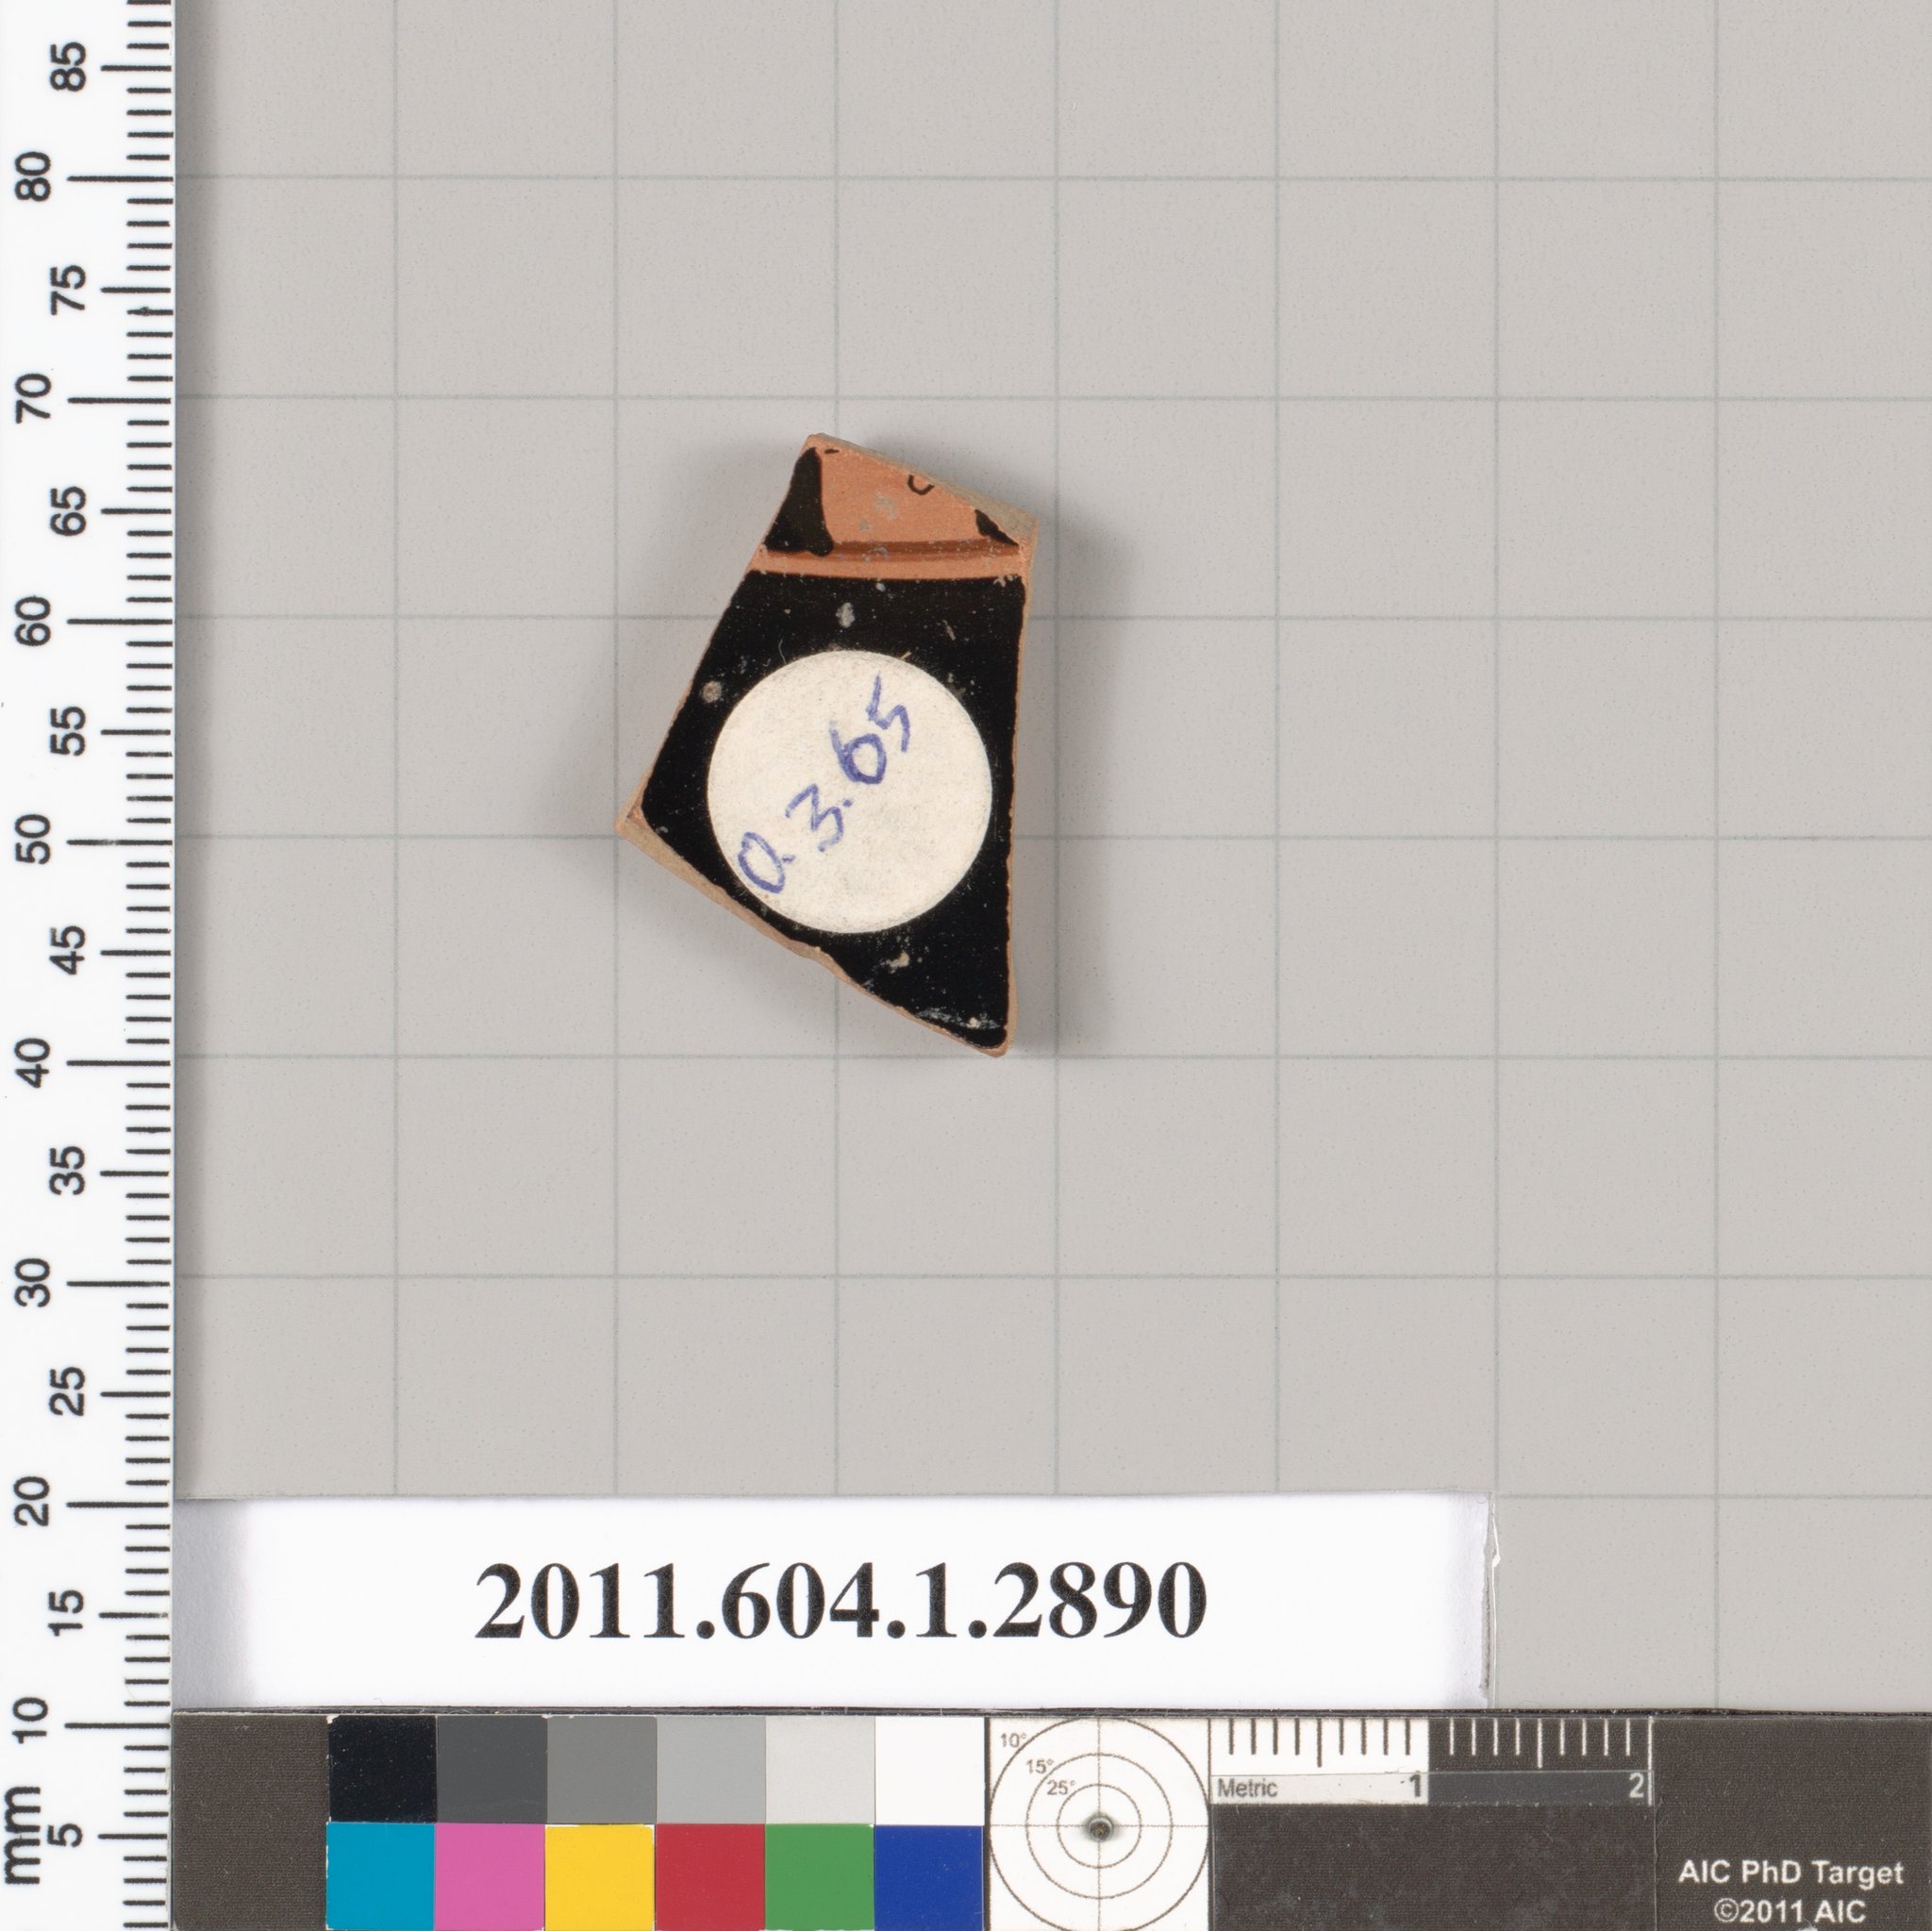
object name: kylix fragment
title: Terracotta fragment of a kylix (drinking cup)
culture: greek, attic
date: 520-500 BCE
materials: terracotta